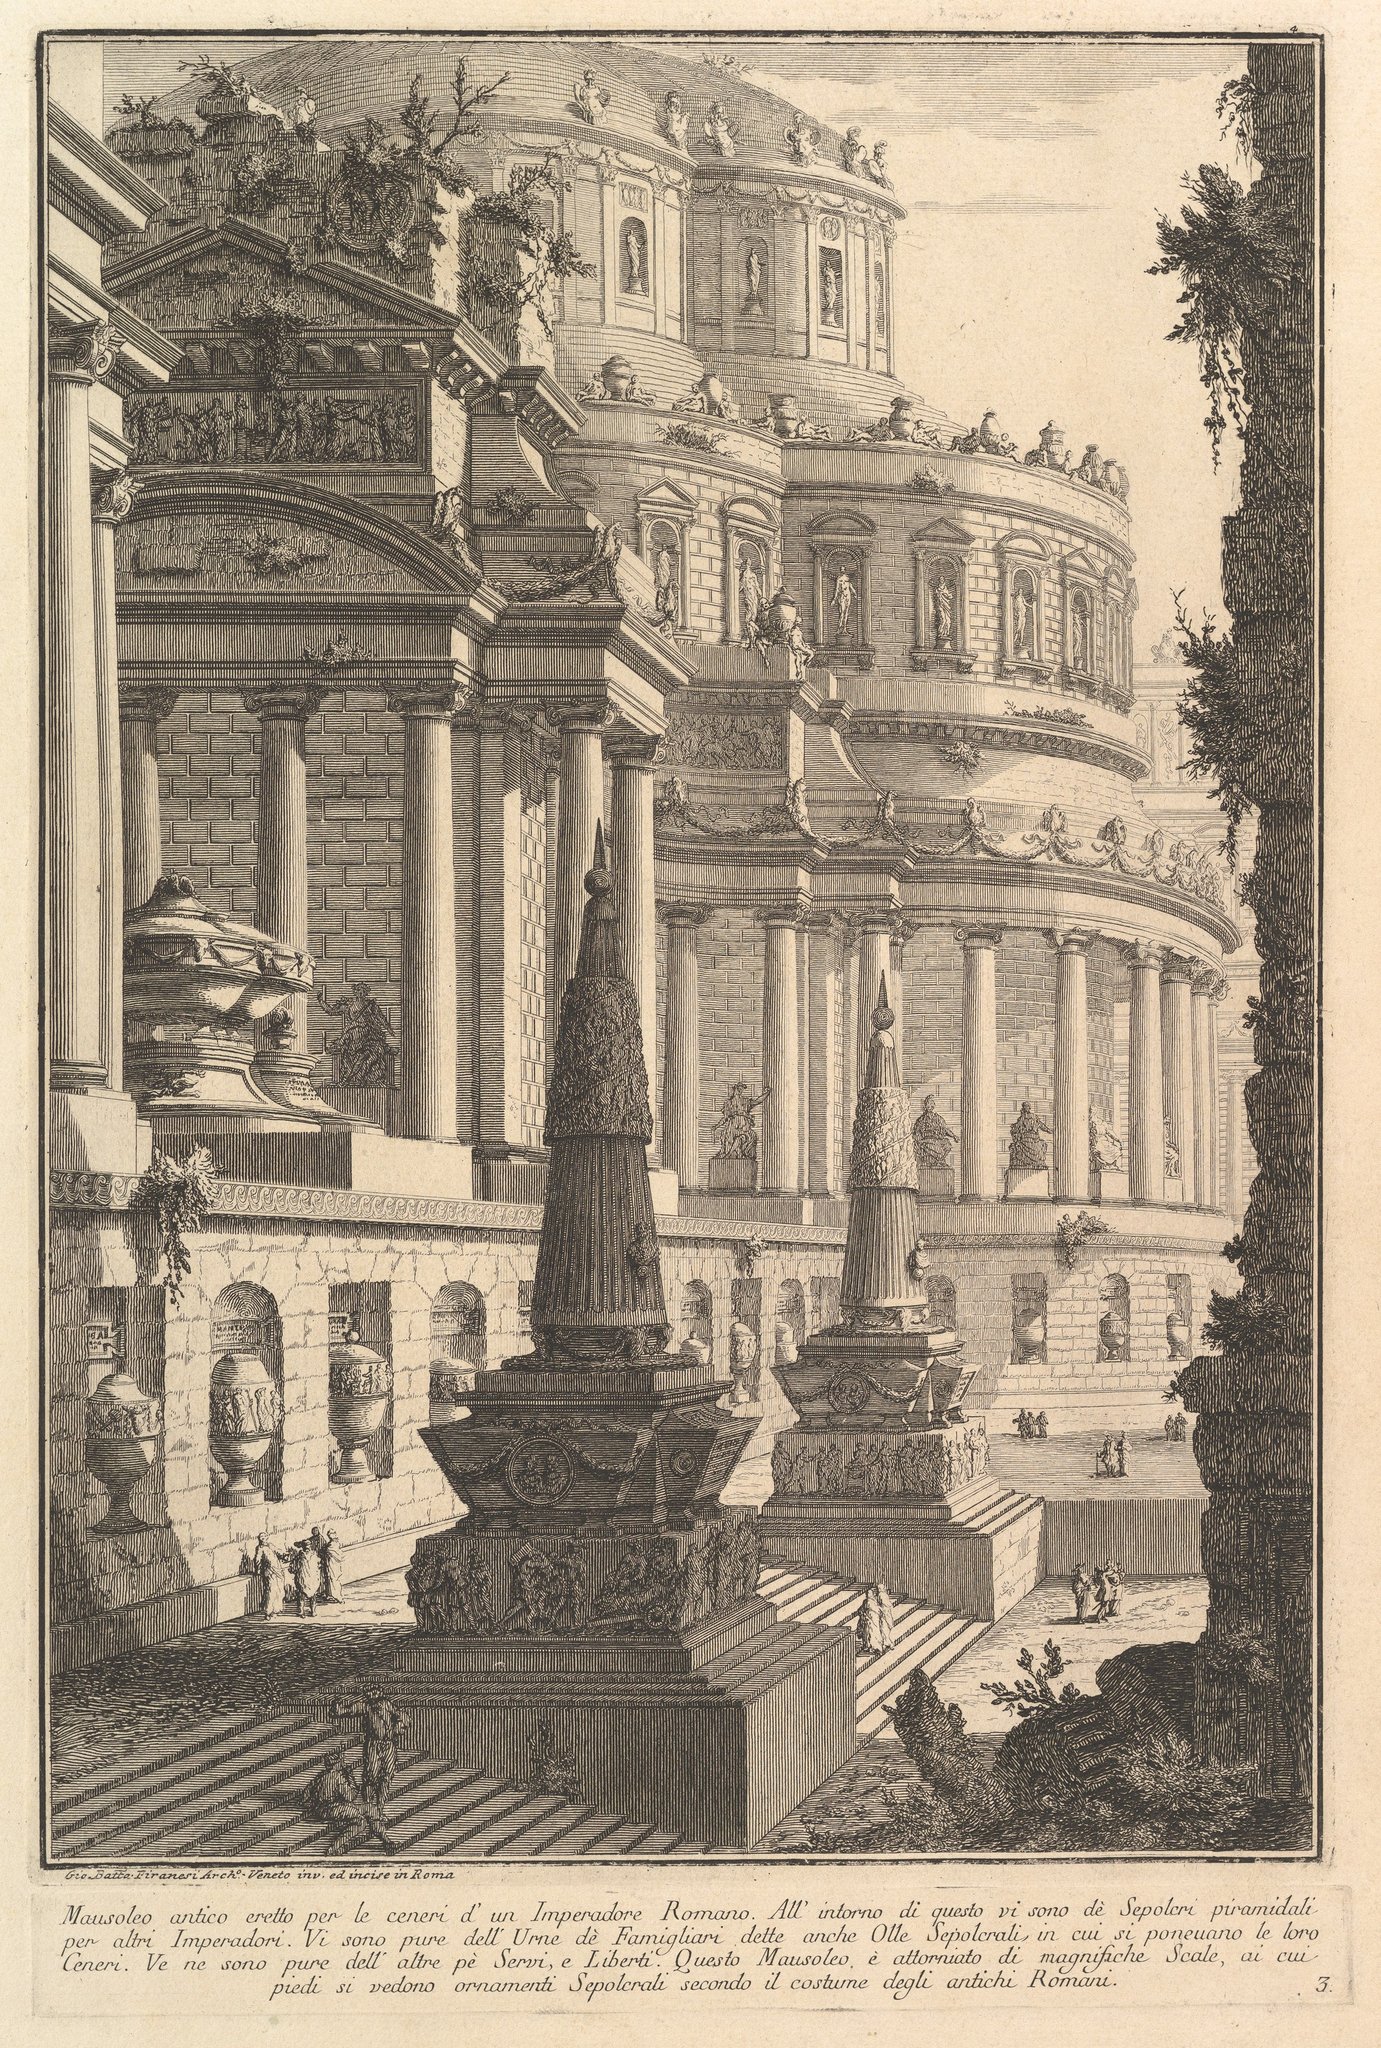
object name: print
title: Ancient mausoleum erected for the ashes of a Roman Emperor (Mausoleo antico eretto per le ceneri d'un Imperadore Romano), from "Prima Parte di Architettura, e Prospettive"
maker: giovanni battista piranesi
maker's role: artist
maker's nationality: italian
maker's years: 1720-1778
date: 1750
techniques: etching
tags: architecture,buildings